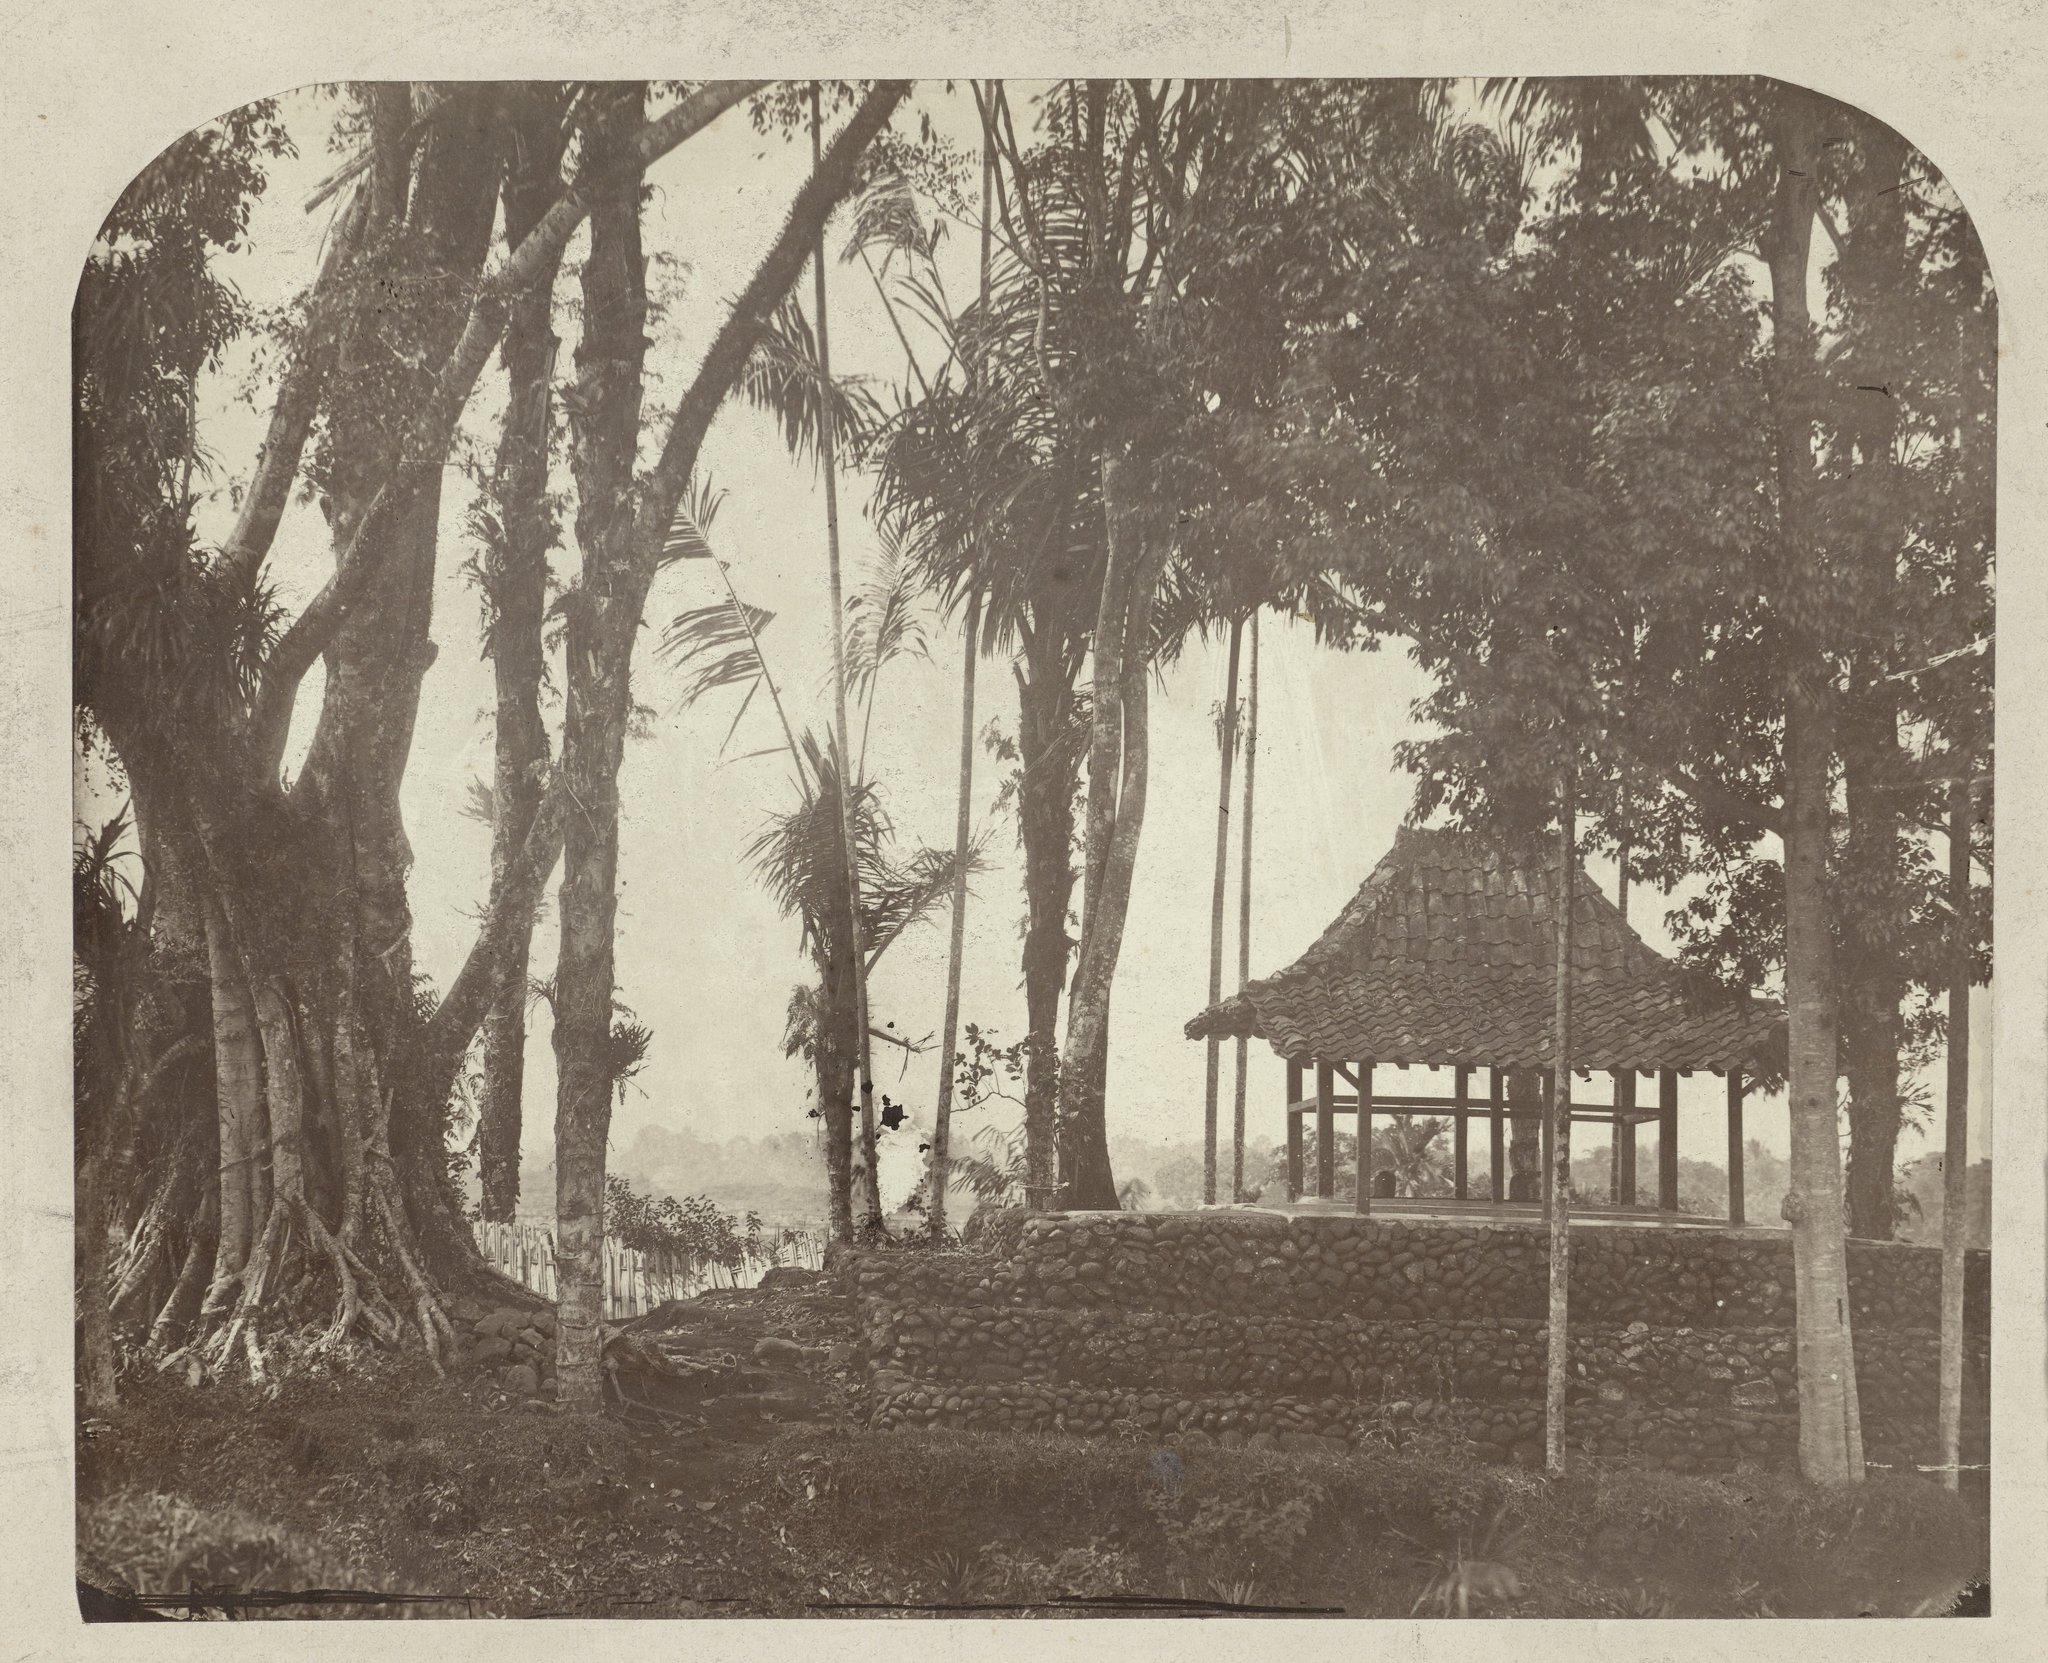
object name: photograph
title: Supposed grave of depatie Olah, founder of the Pajajaran dynasty, the last Hindu kingdom in West Java.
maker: isidore kinsbergen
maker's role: fotograaf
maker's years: 1821-1905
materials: cardboard, paper, photographic support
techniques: albumen print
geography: java